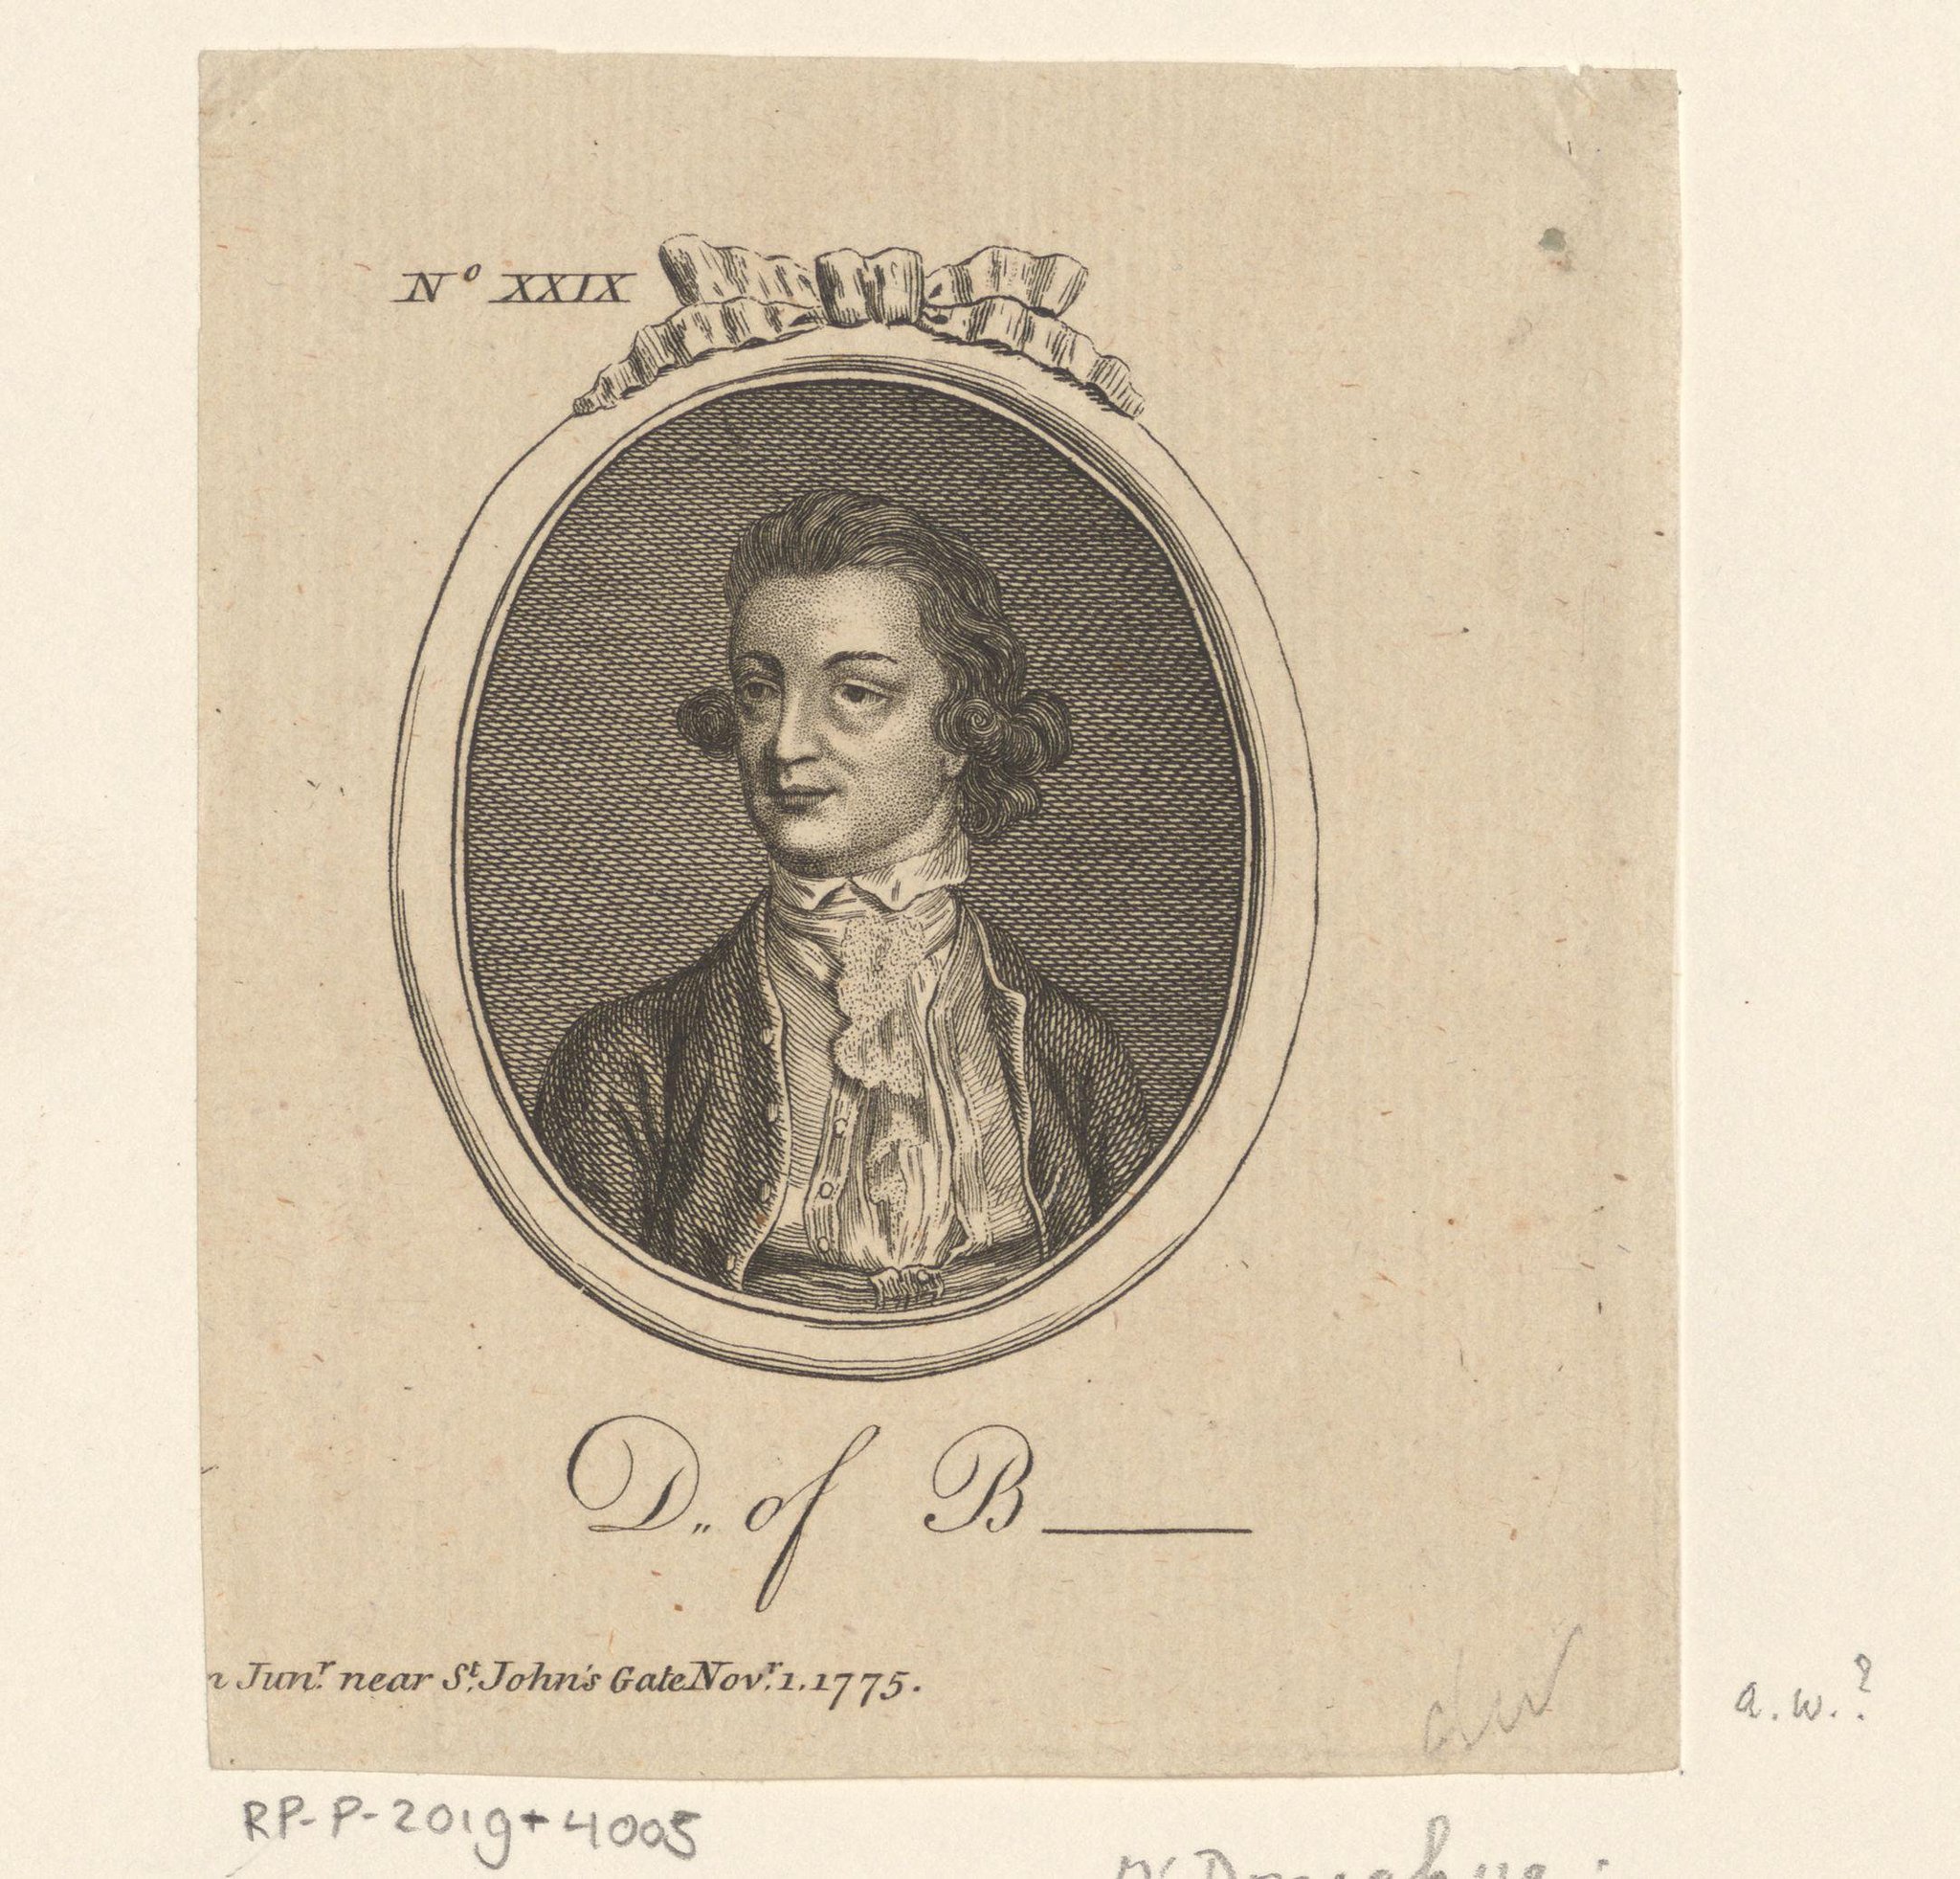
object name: print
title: Portret van een onbekende man, aangeduid als D. of B...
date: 1775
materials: paper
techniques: etching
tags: historical persons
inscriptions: collector's mark: Lugt 2228